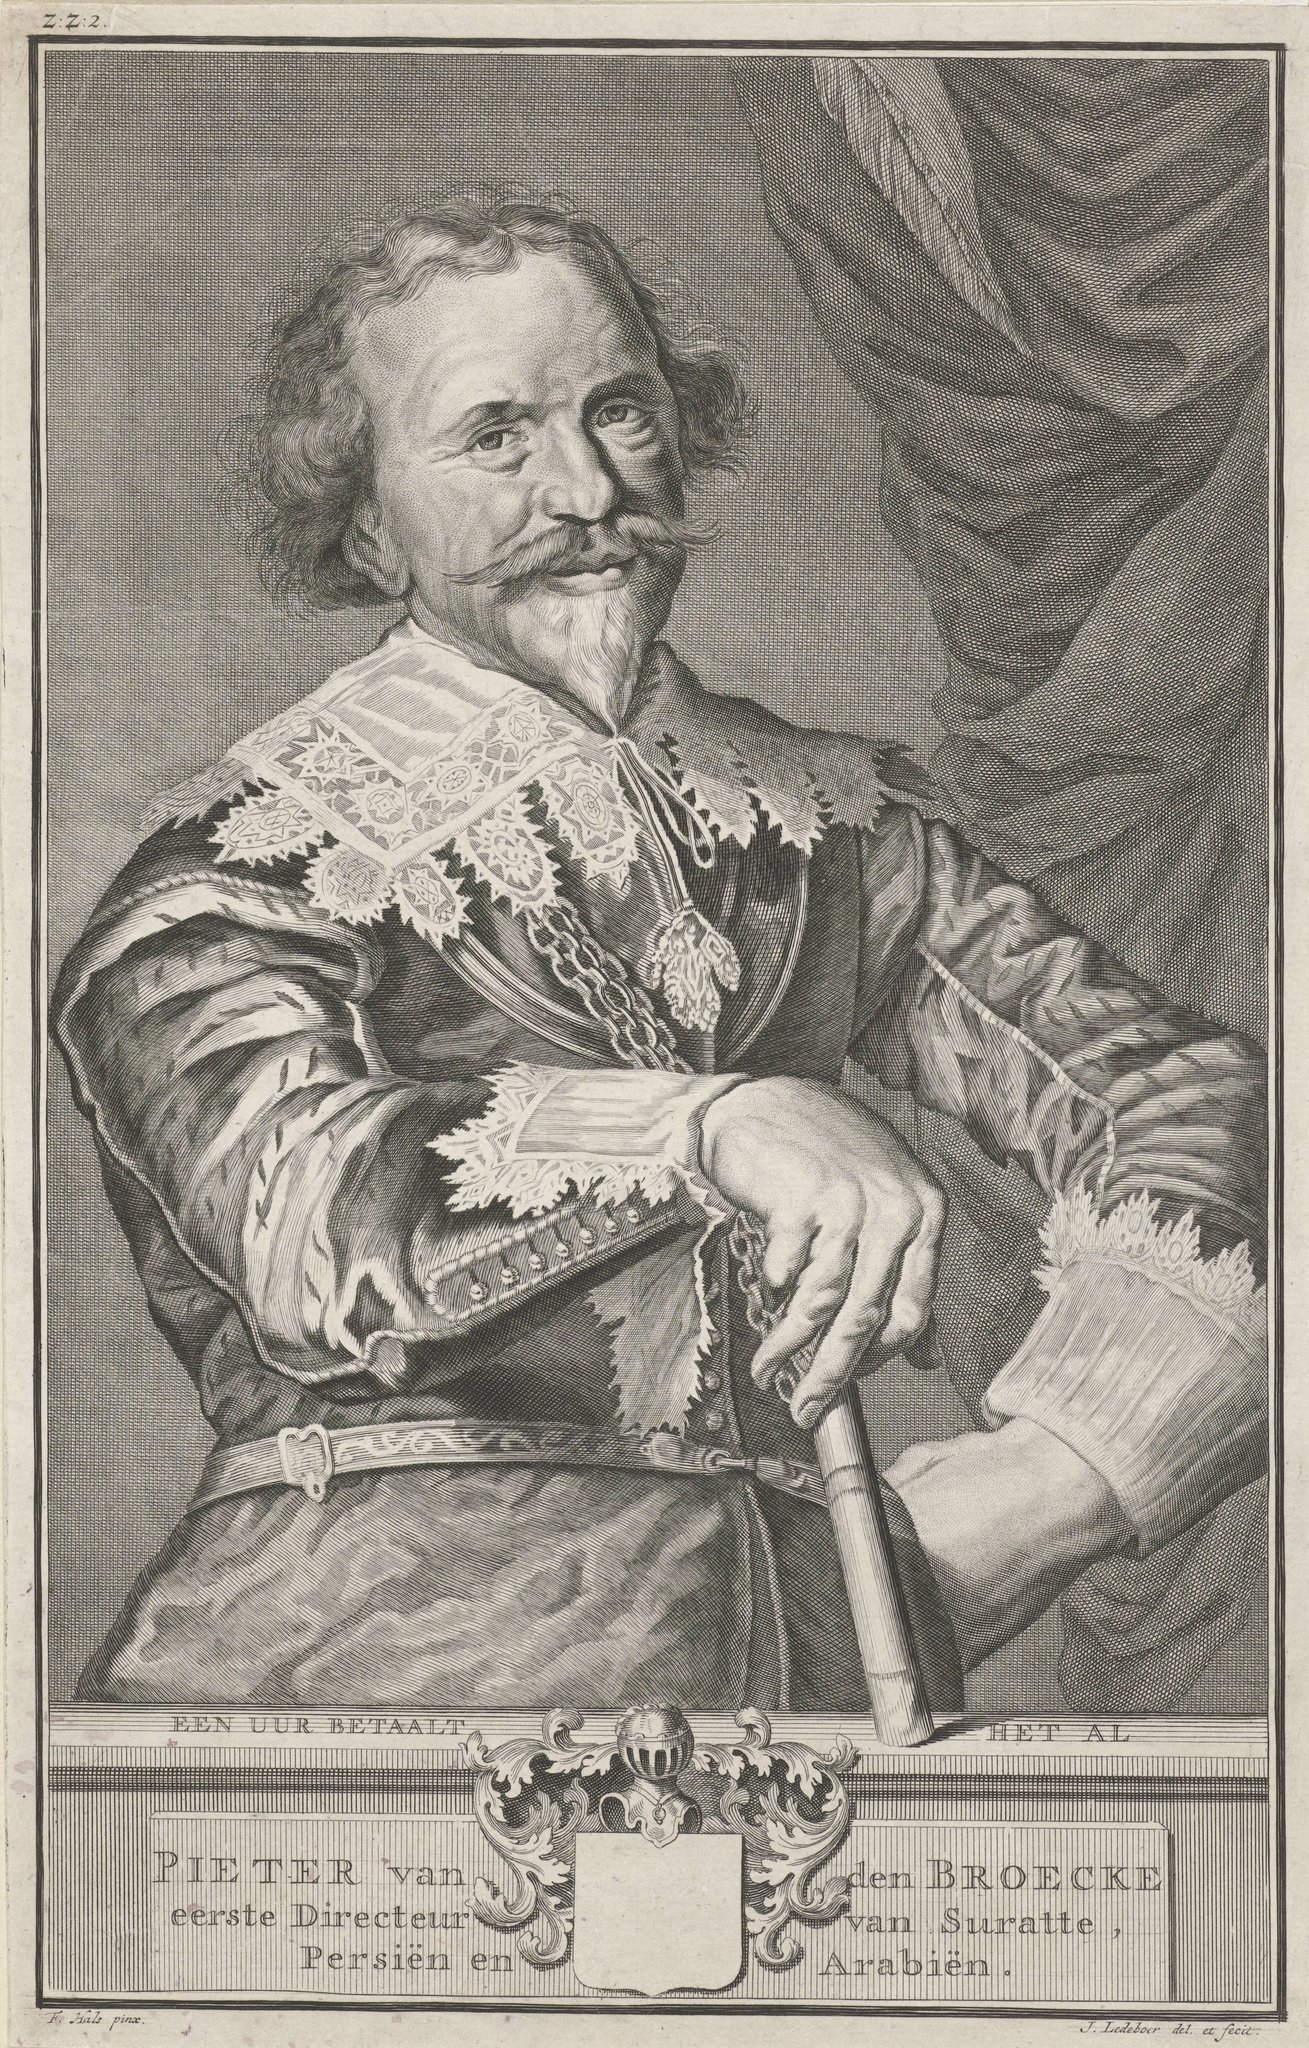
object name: print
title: Portret van Pieter van den Broecke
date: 1702-1749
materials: paper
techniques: engraving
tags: antwerp, pieter van den broecke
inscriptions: collector's mark: Lugt 2228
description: Portret ten halven lijve naar rechts van Pieter van den Broecke, koopman en bewindhebber, blootshoofds en leunend op een commandostaf. Onder het portret staat op de plint een zinspreuk, gevolgd door de naam, titels en het nog nader te graveren wapenschild van de geportretteerde. Prent linksboven gemerkt: Z:Z: 2.